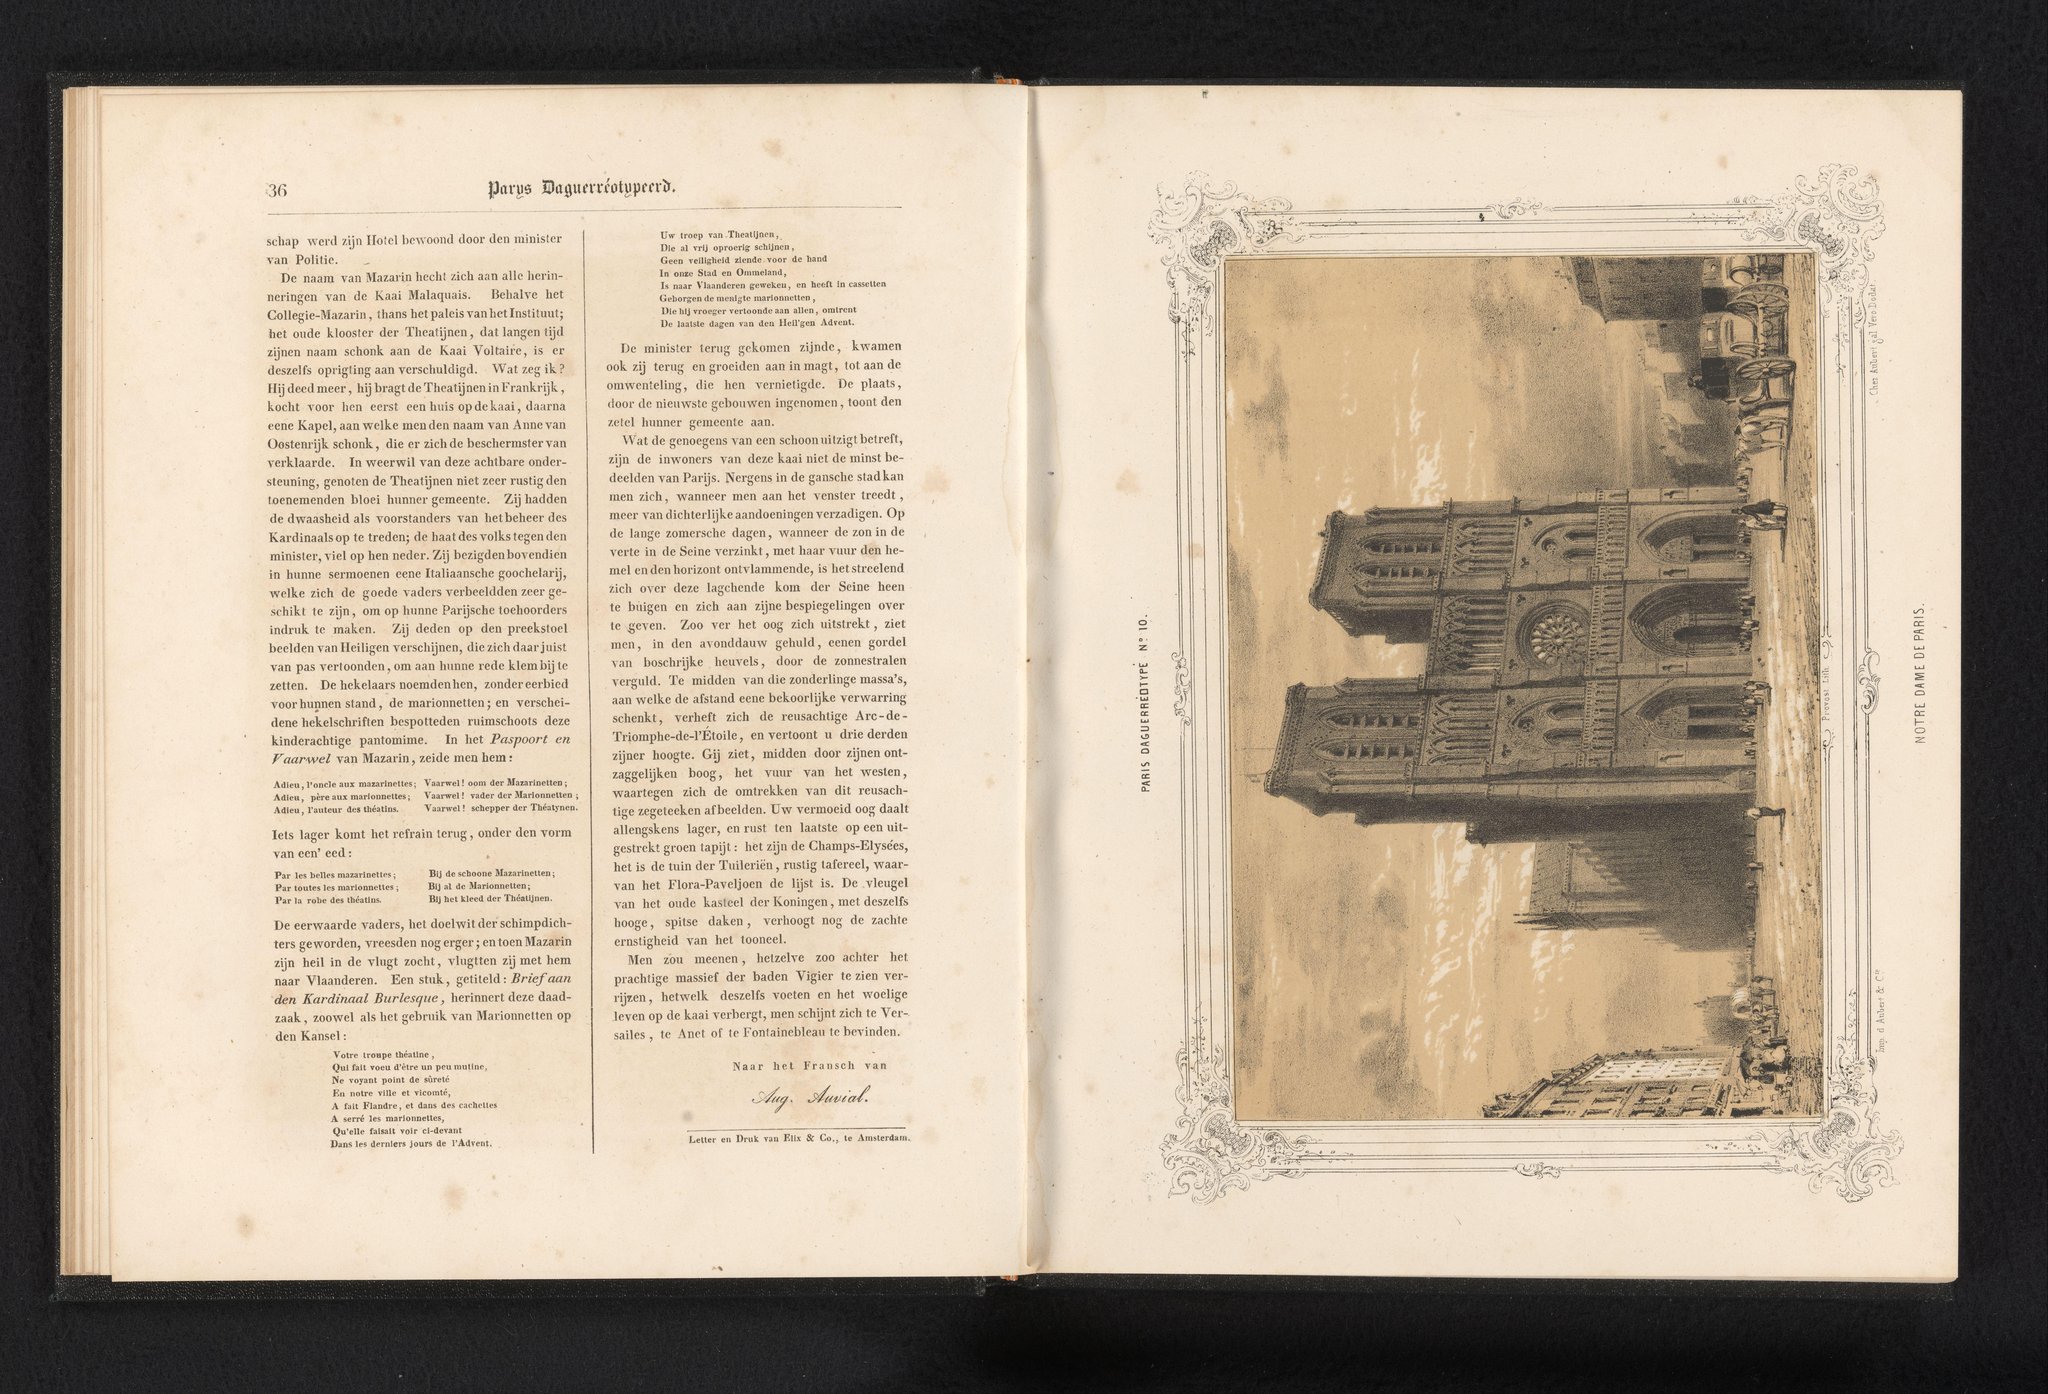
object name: page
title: Gezicht op de Notre-Dame van Parijs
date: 1839-1840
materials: paper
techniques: tone lithography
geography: paris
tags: church (exterior)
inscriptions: inscription: ‘PARIS DAGUERRÉOTYPÉ No. 10.’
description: Prent op zevenendertigste ongenummerde pagina.